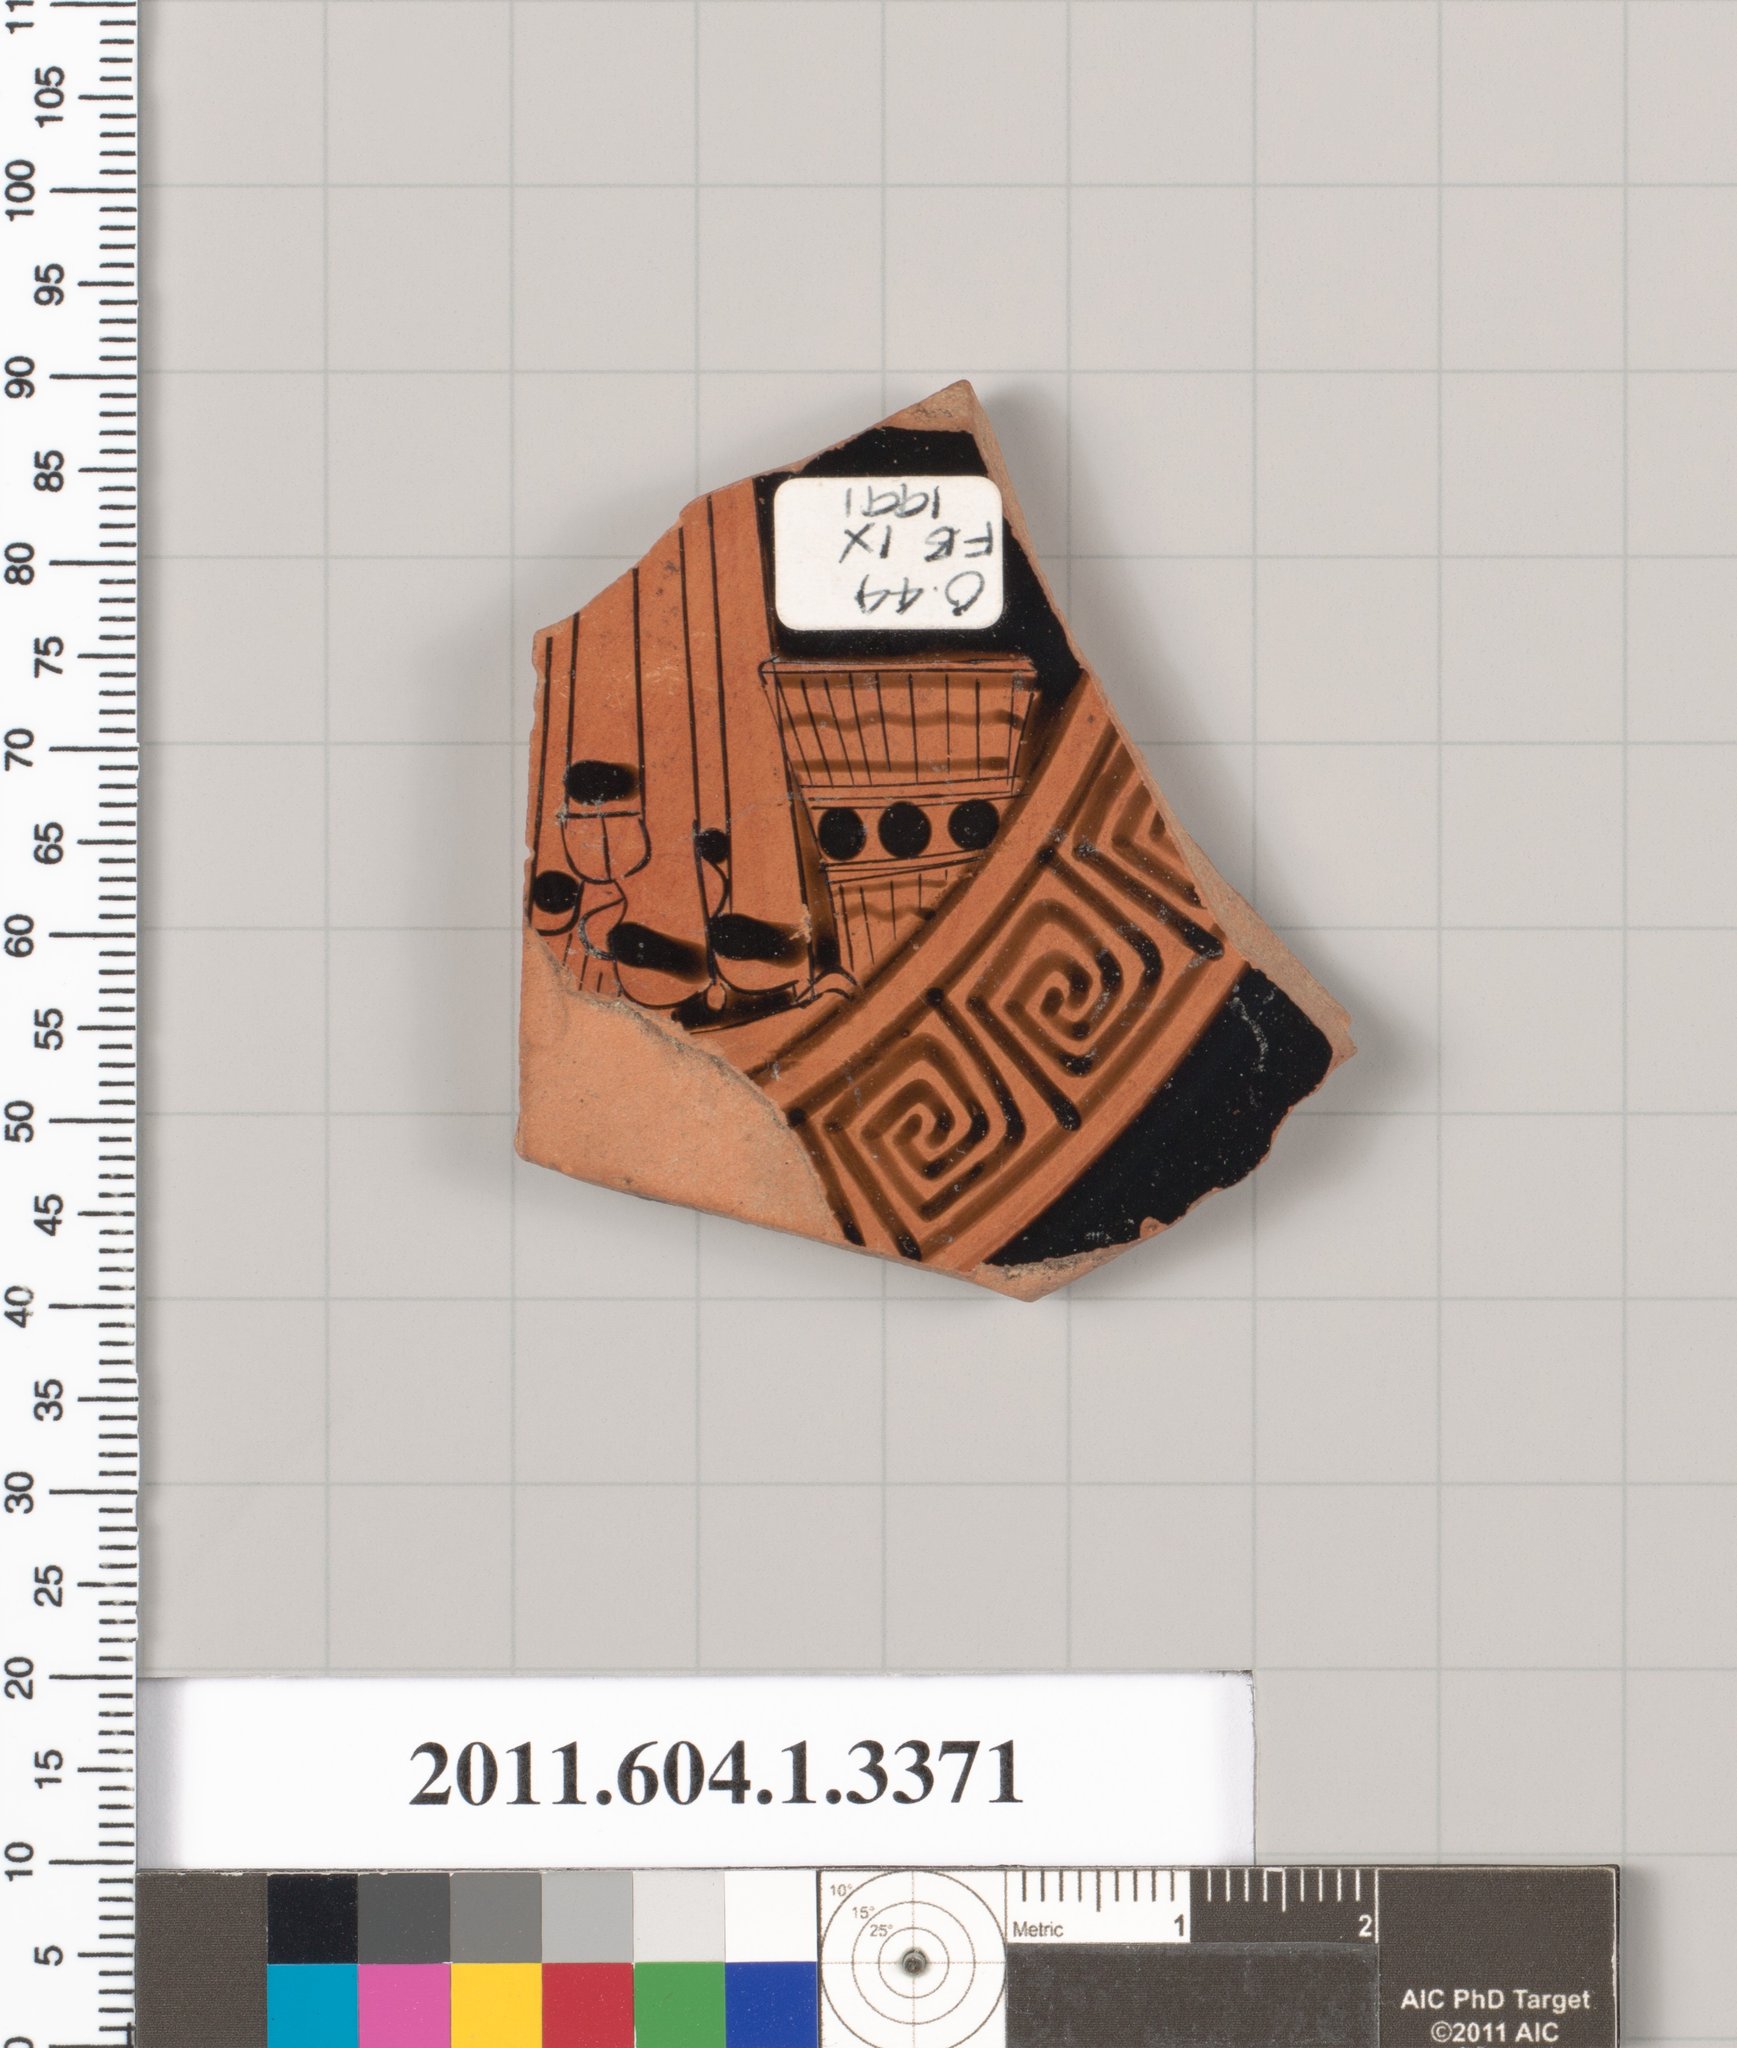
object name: kylix fragment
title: Terracotta fragment of a kylix (drinking cup)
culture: greek, attic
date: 475-451 BCE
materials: terracotta